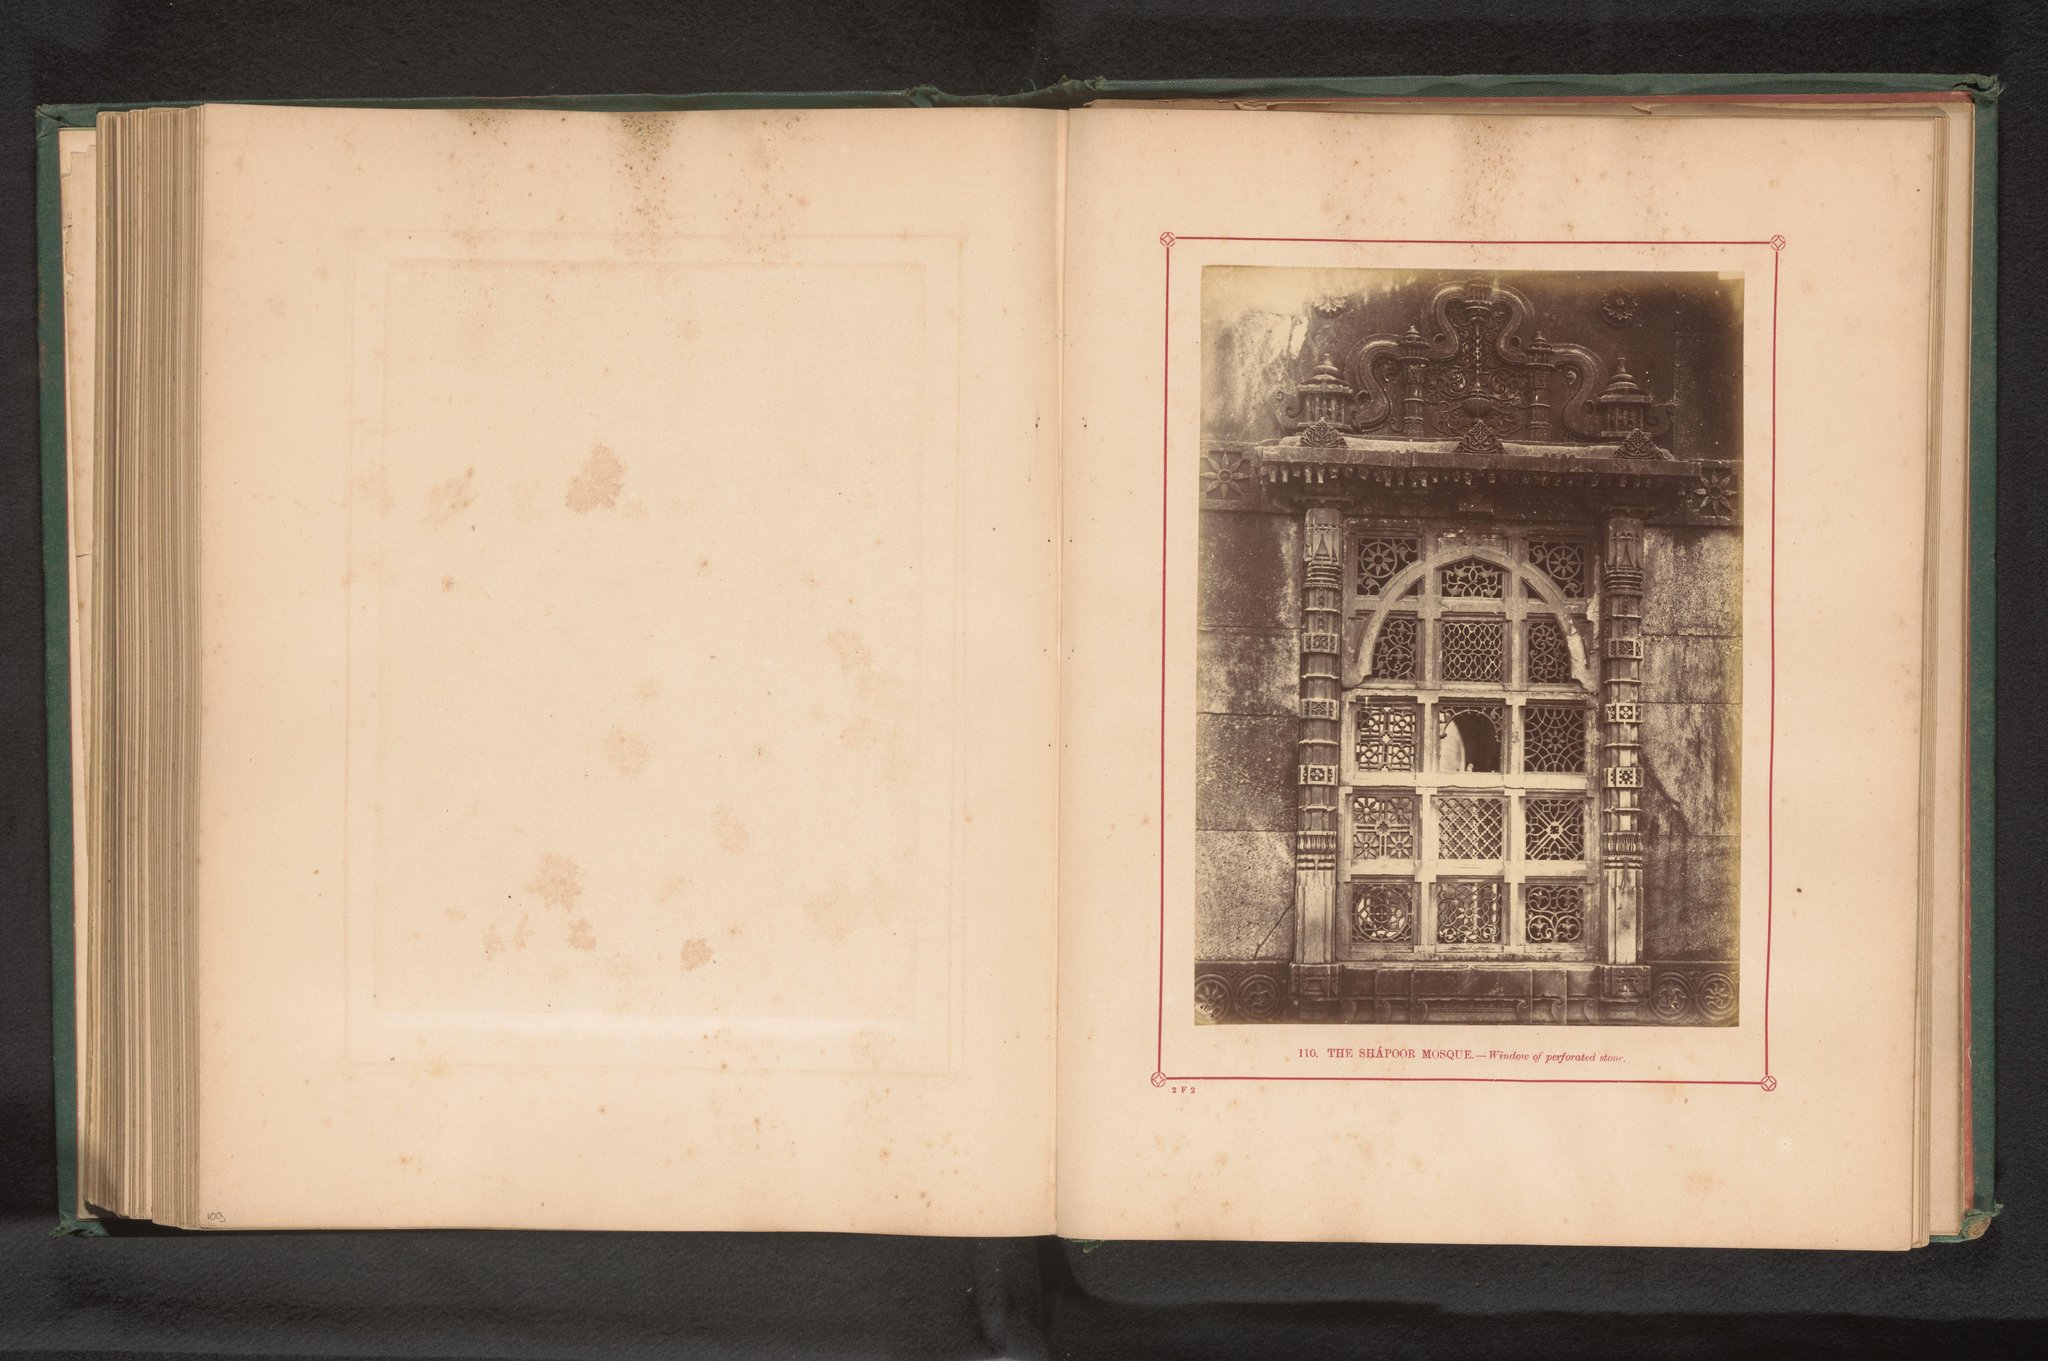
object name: page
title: Raam van de Shapoor-moskee in Ahmedabad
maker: thomas biggs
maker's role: fotograaf, kapitein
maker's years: 1822-1905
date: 1856-1866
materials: photographic support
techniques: albumen print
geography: ahmedabad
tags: window, temple, shrine ~ islam, mohammedanism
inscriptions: number: ‘110.’, inscription: ‘2F2’